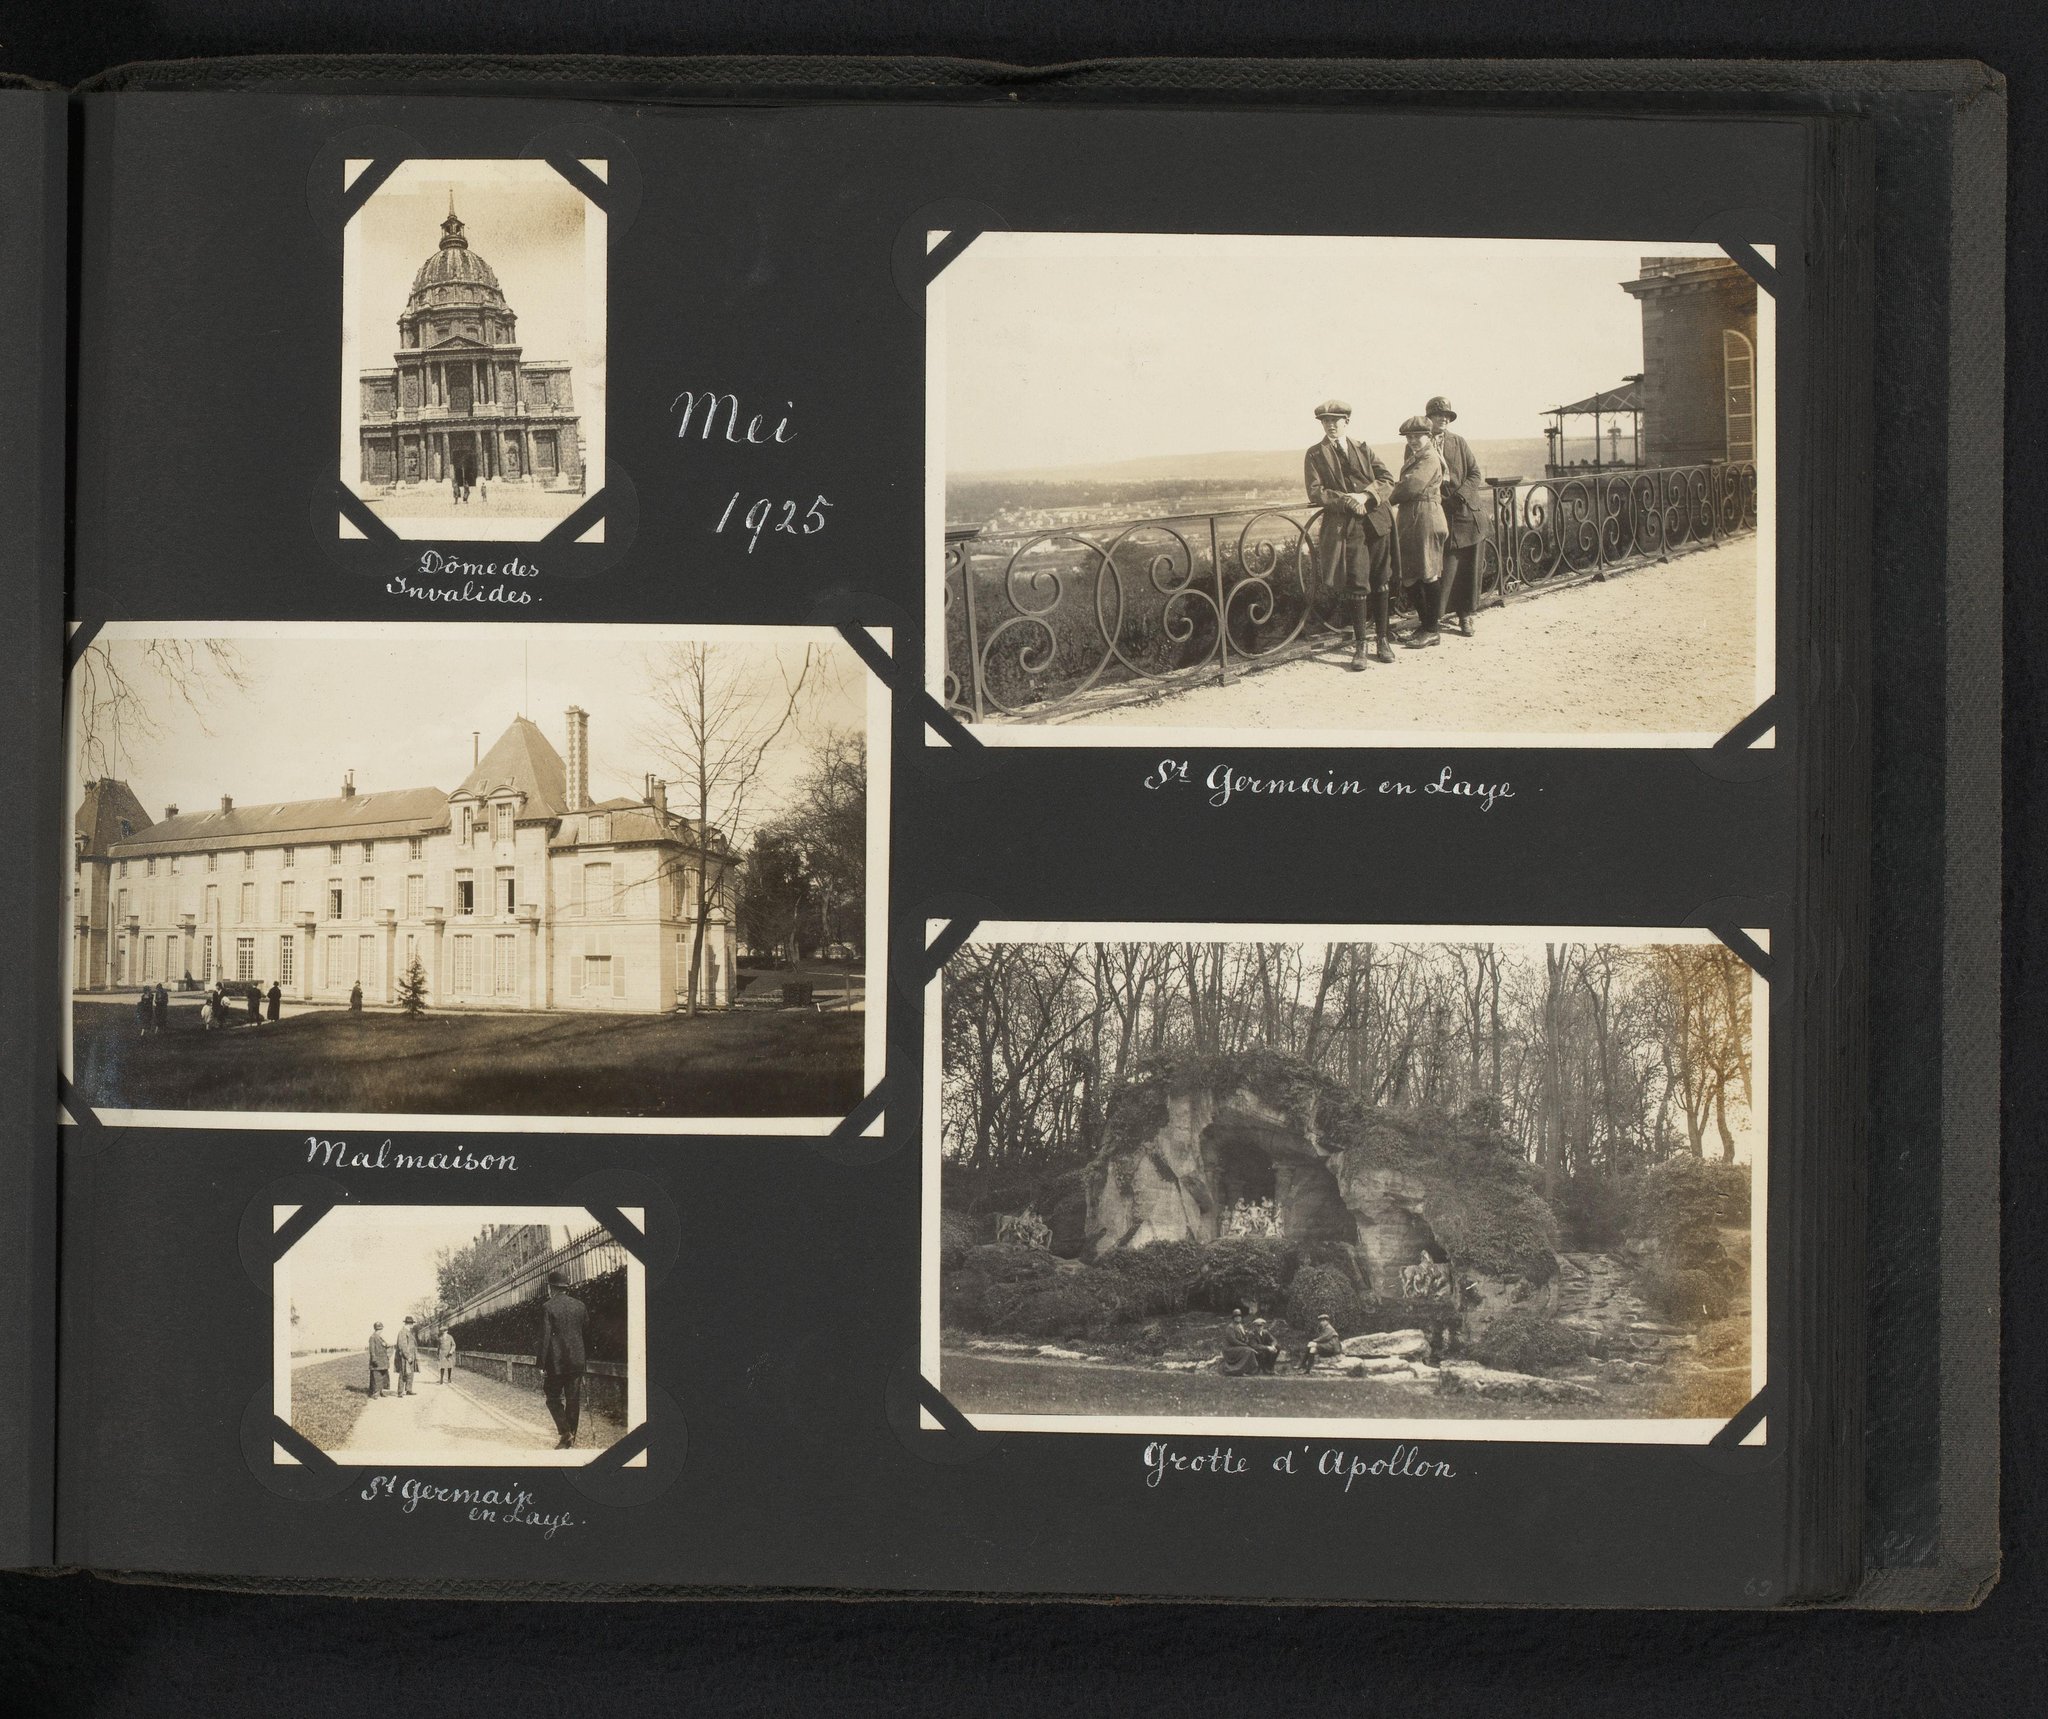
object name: photograph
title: Mei 1925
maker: hendrik herman van den berg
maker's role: amateurfotograaf, jurist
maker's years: 1875-1944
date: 1905-1925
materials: paper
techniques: gelatin silver print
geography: france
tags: the hague, caroline louise van den berg-van den berg, carel frederik van den berg (cay), amsterdam, frank willem van den berg (1912-1998), the family travelling, on holiday, castle, paris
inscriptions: inscription: ‘St Germain en Laye’, inscription: ‘Malmaison’, inscription: ‘Dôme des/ Invalides’, inscription: ‘St Germain/ en Laye’, inscription: ‘Grotte d'Apollon’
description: Deze foto's maken deel uit van een album.